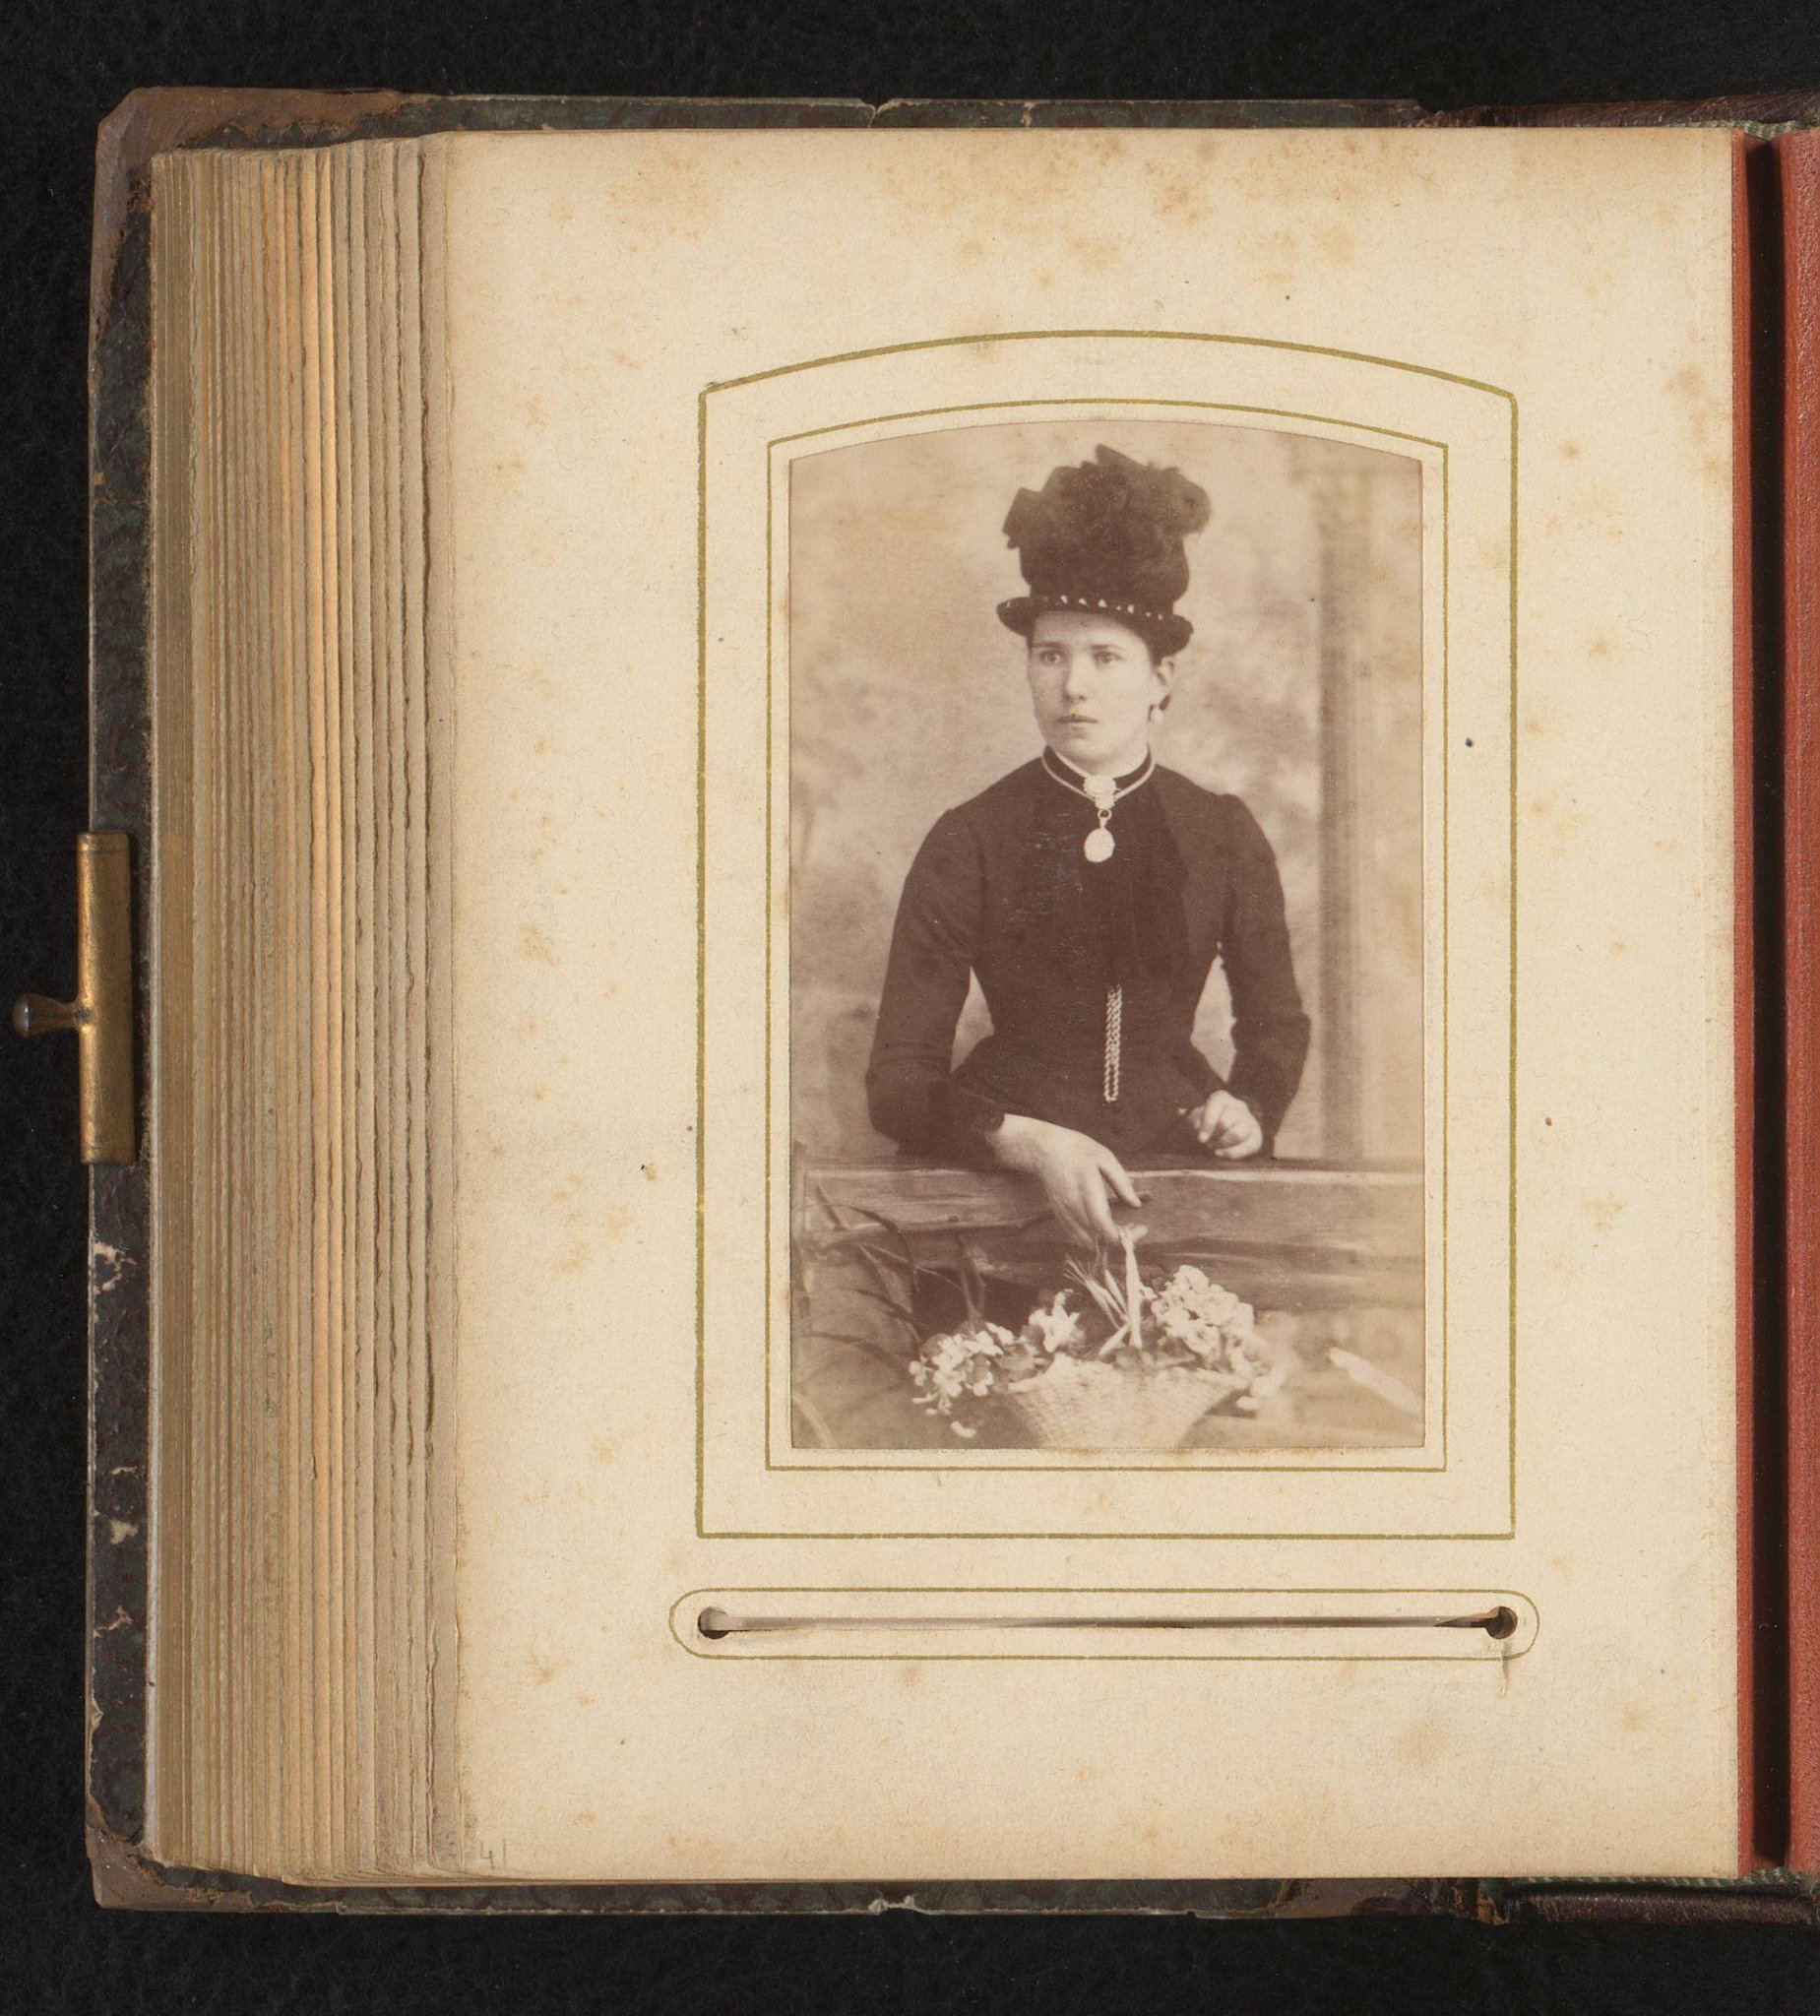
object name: album leaf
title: Portret van een vrouw met hoed en ketting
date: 1860-1890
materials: cardboard, photographic support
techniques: albumen print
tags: adult woman, head-gear, historical persons, necklace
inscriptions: inscription: ‘Artist/ and/ Photographers/ Cambridge Villa/ 103, Seven Sisters Road, N./ Johnston & Co./ 60, High Street/ Stoke Newington’